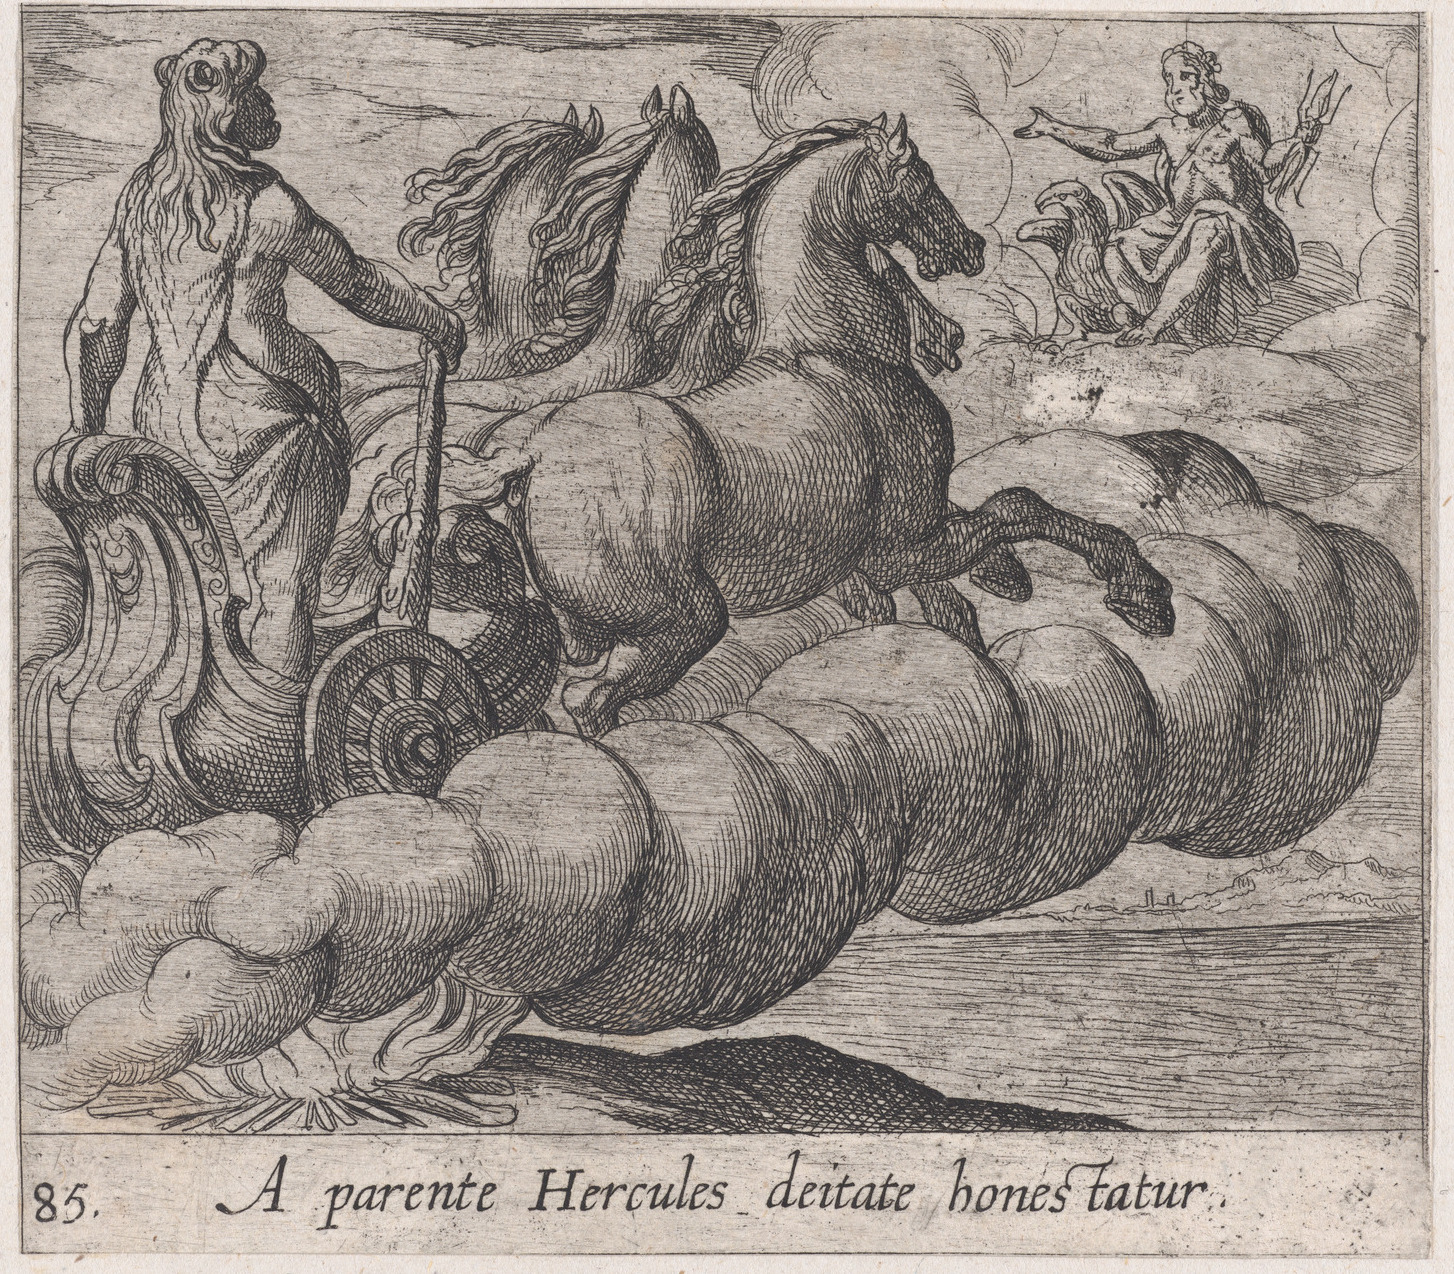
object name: print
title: Plate 85: The Immortalization of Hercules (A parente Hercules deitate honestatur), from Ovid's 'Metamorphoses'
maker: antonio tempesta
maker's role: artist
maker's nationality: italian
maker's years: 1555-1630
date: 1606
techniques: etching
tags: hercules,horses,chariots